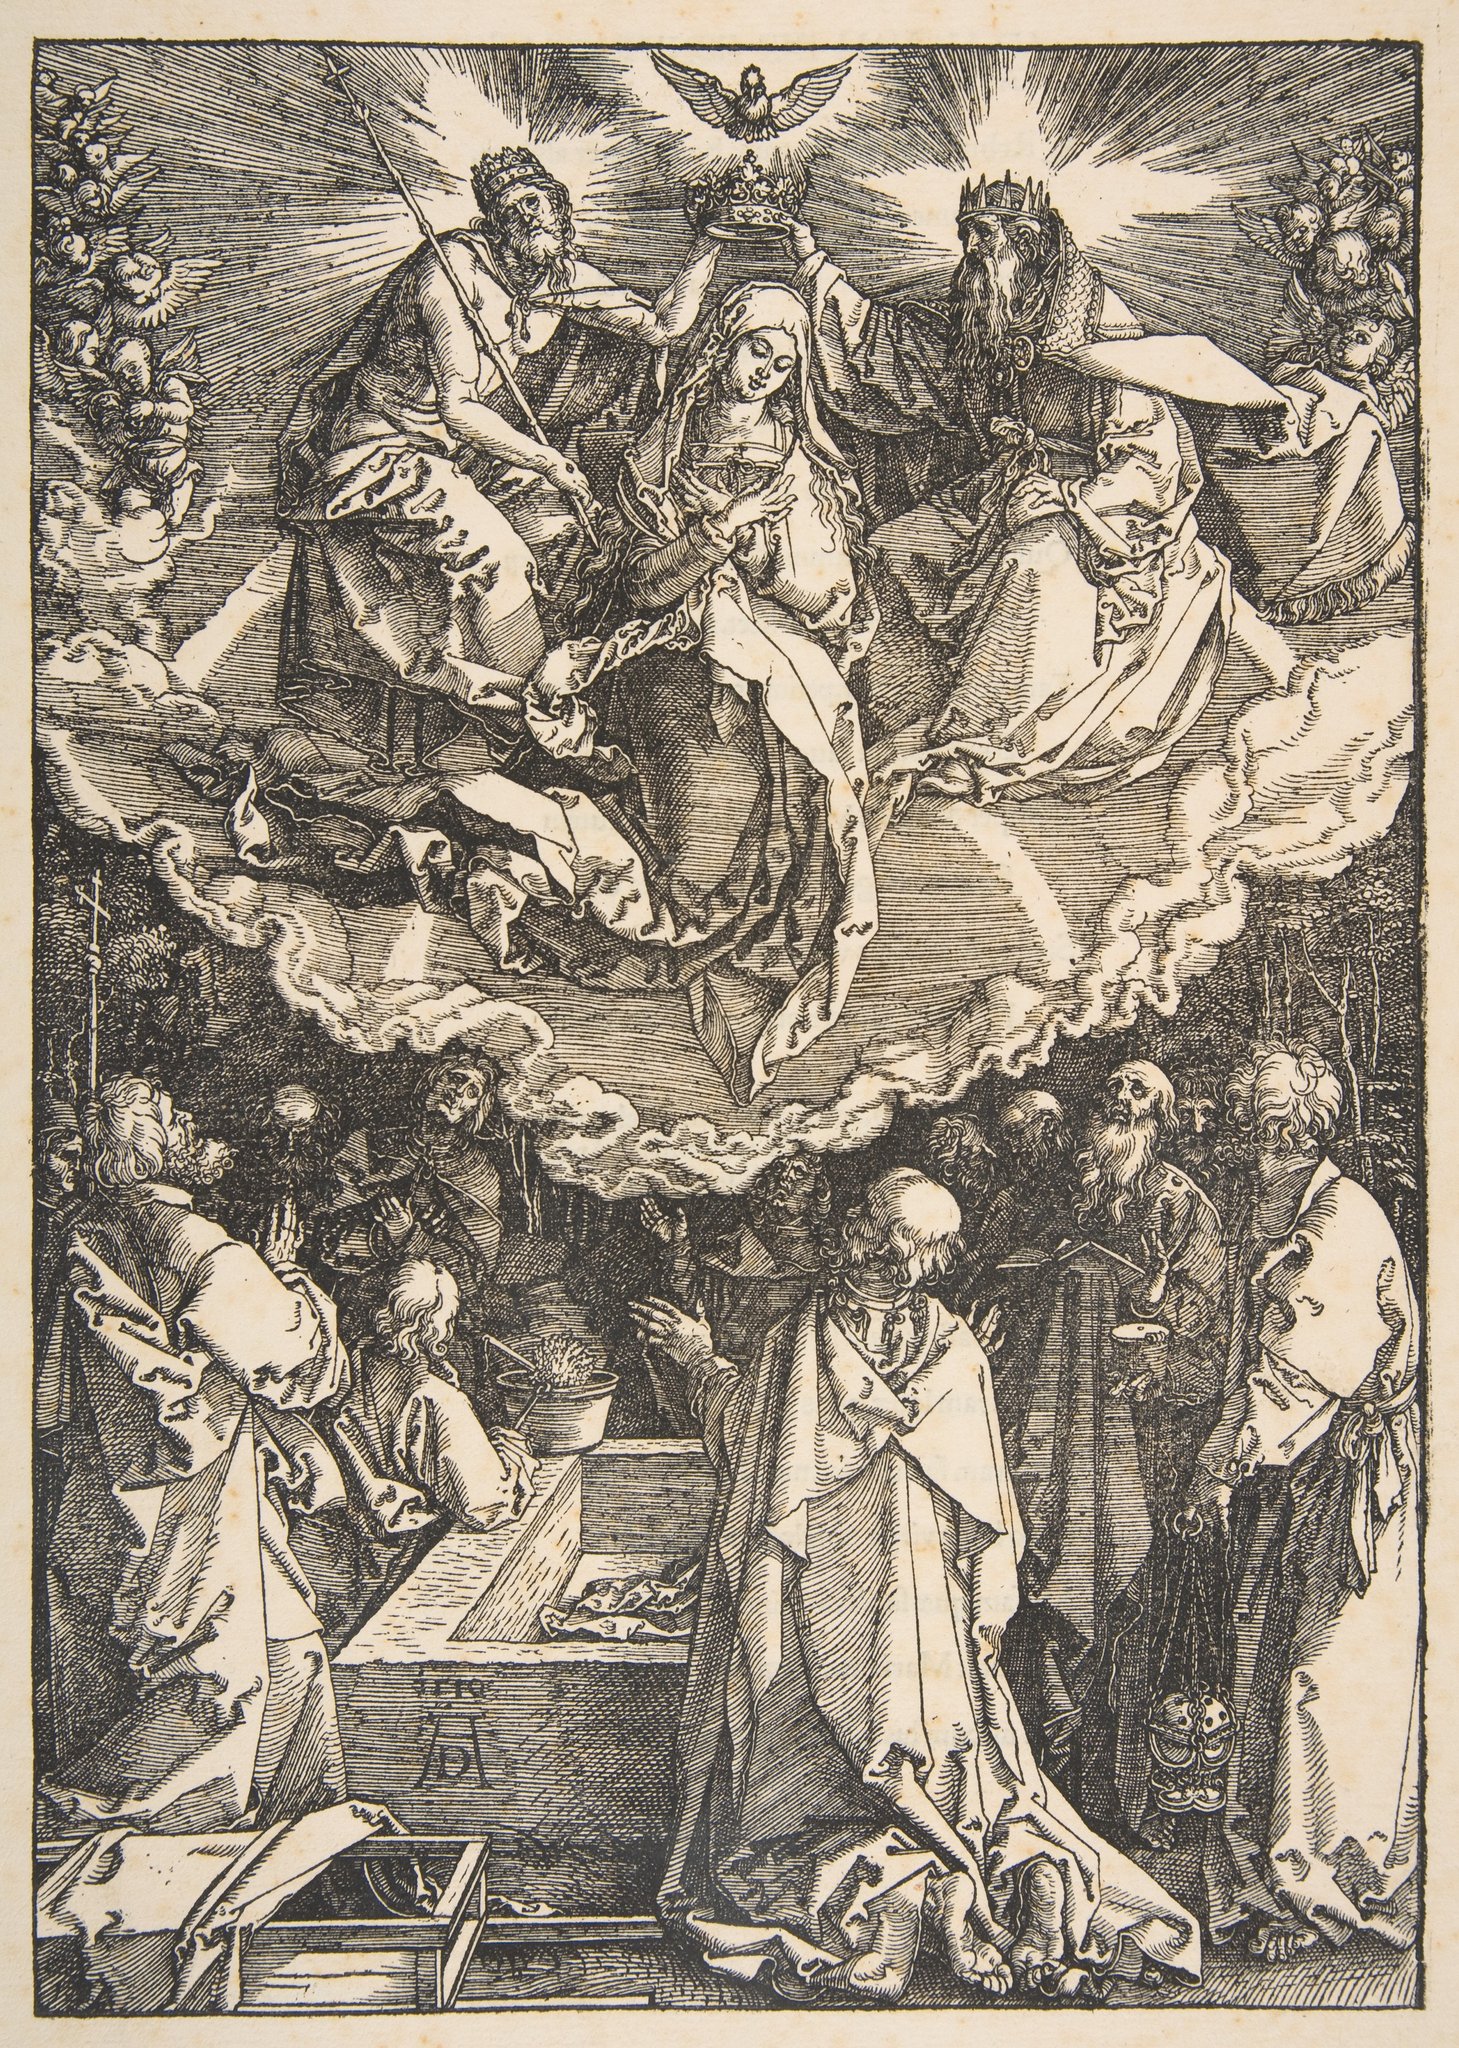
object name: print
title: The Assumption and Coronation of the Virgin, from "The Life of the Virgin"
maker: albrecht dürer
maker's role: artist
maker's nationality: german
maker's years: 1471-1528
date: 1510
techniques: woodcut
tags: assumption of the virgin